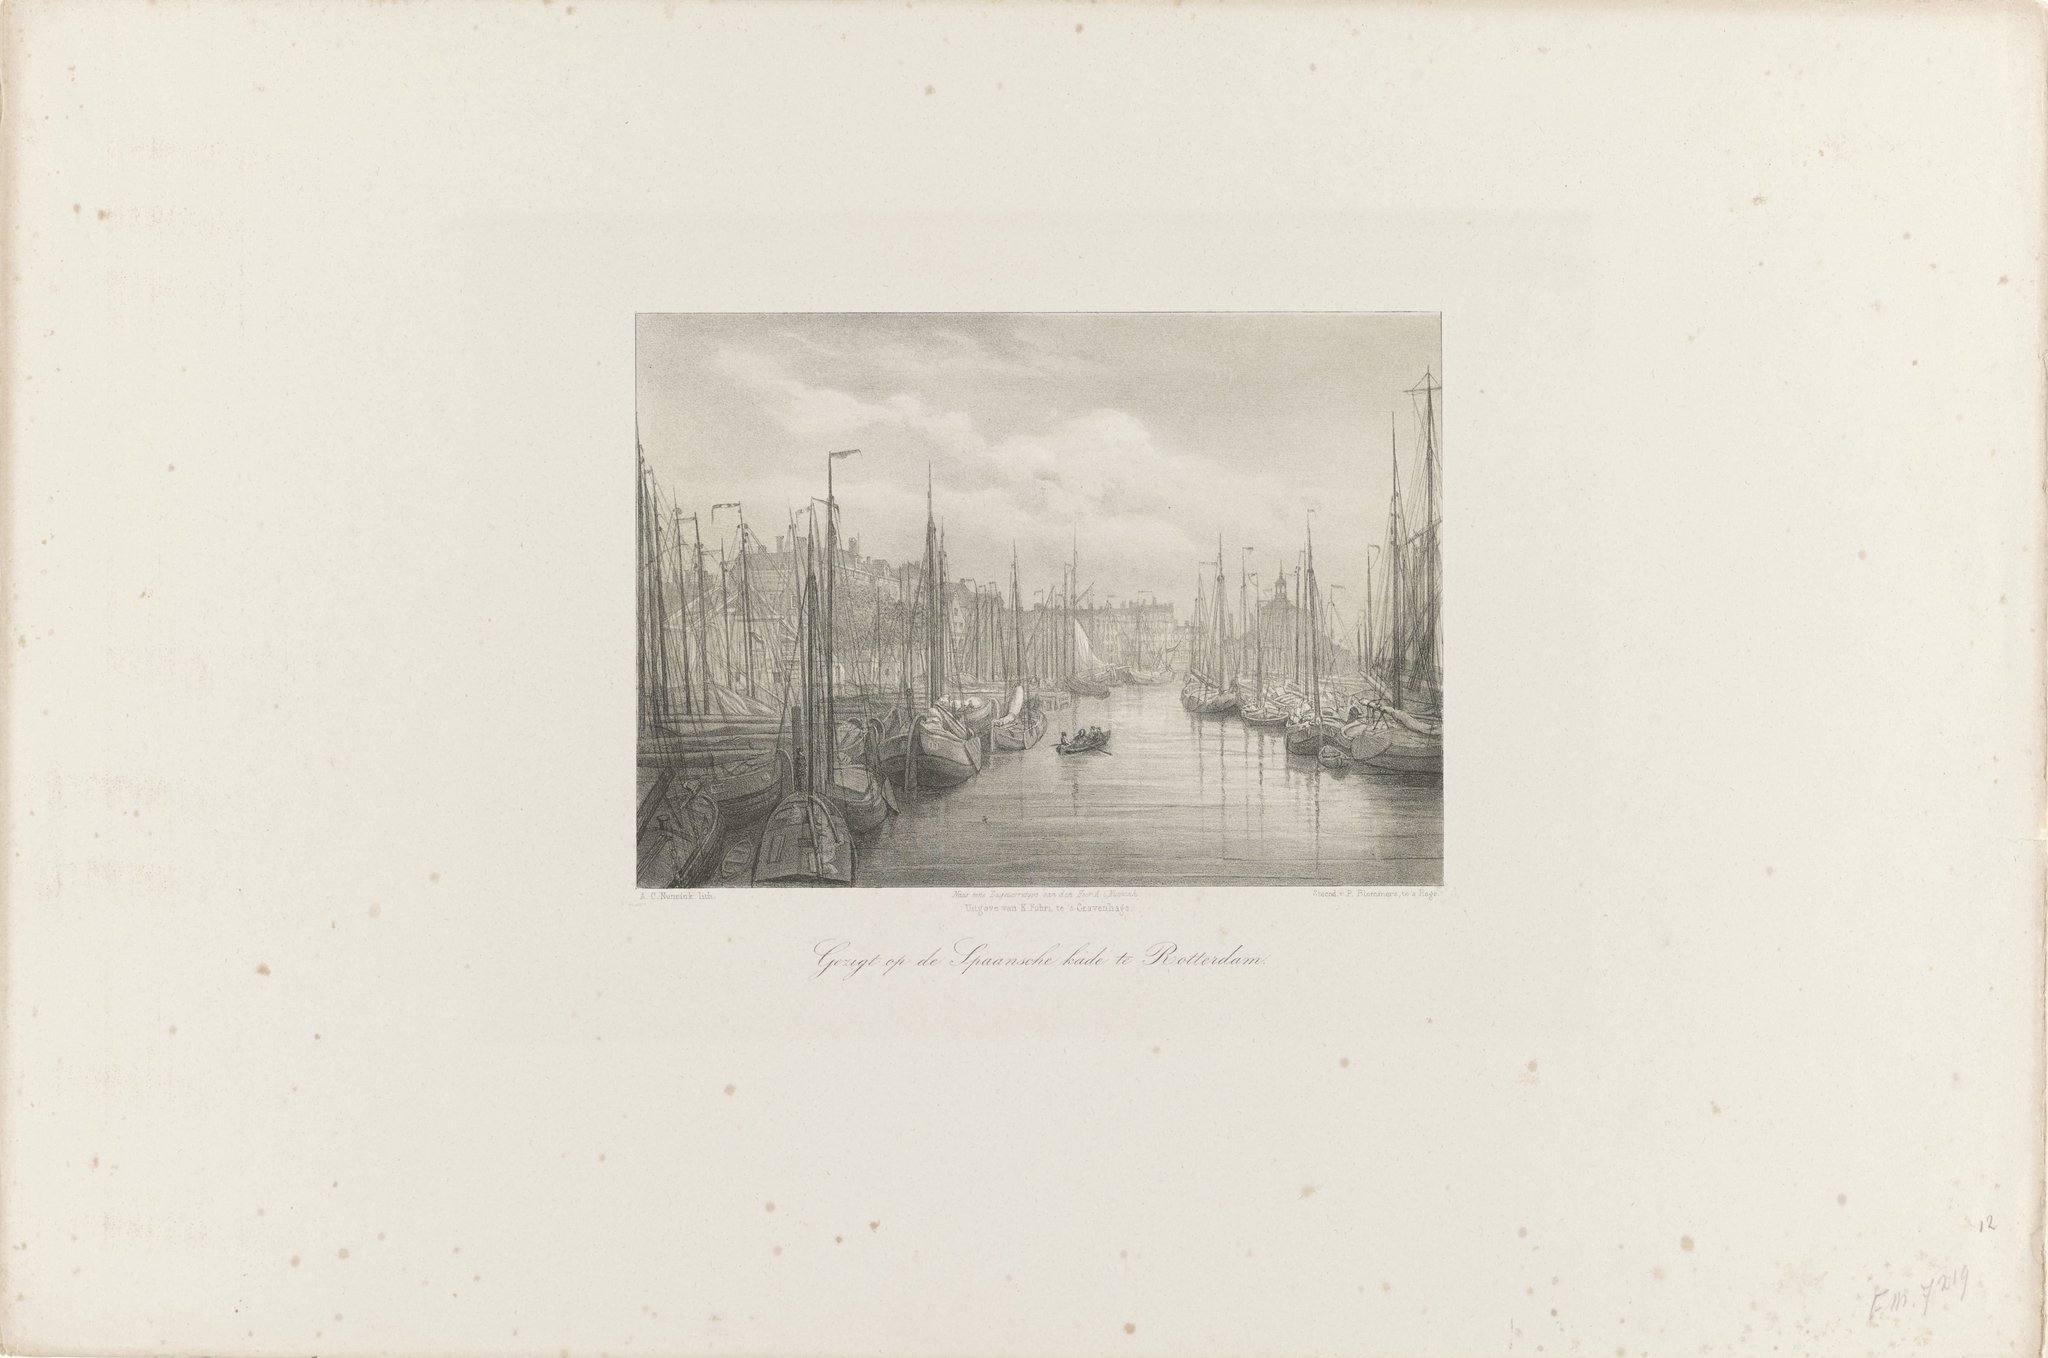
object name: print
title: Gezicht op de Spaansekade te Rotterdam, 1854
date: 1855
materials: paper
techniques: tone lithography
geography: netherlands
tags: rotterdam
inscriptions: collector's mark: Lugt 2228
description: Gezicht op de Spaansekade te Rotterdam. Onderdeel van een serie van twaalf portretten naar daguerrotypieën en twaalf stadsgezichten. Ter gelegenheid van het Muziekfeest ter viering van het 25-jarige bestaan van de Maatschappij ter Bevordering van Toonkunst in Rotterdam, 12-15 juli 1854.